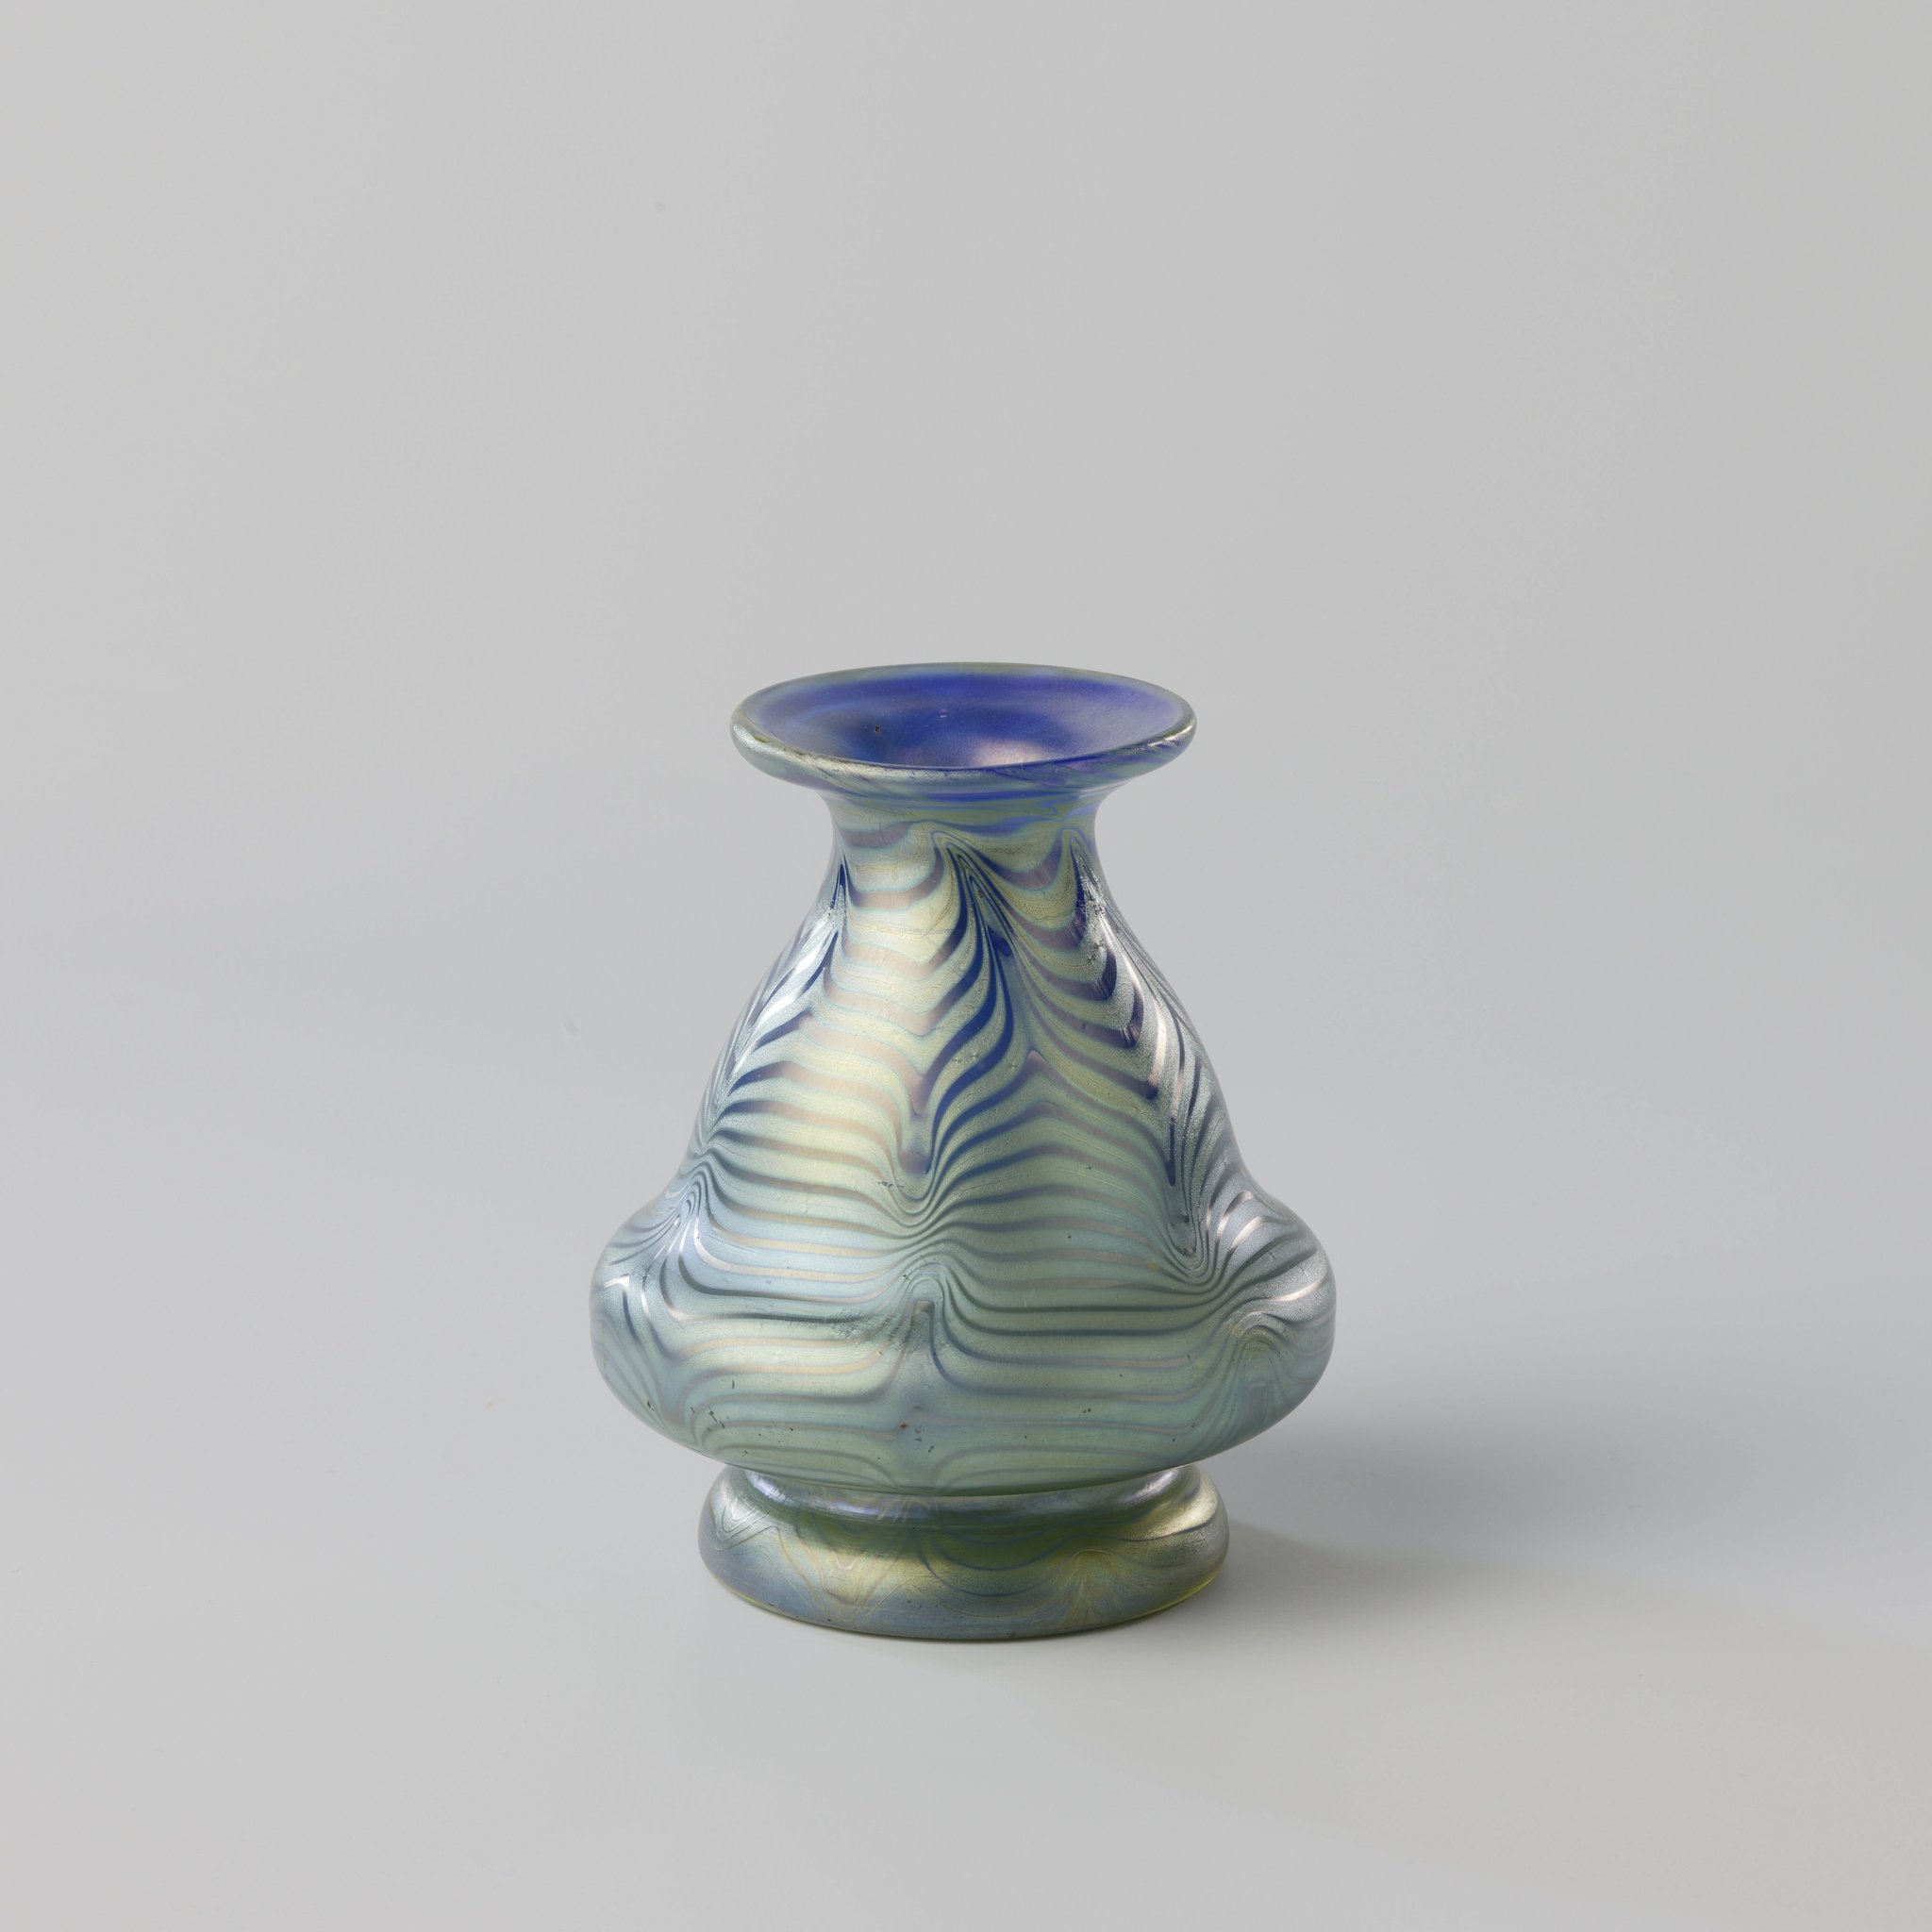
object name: vase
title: Vaas met groene en zilverkleurige draden en een zilverkleurige irisering op een blauw fond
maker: franz hofstötter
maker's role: painter, sculptor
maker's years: 1871-1958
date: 1899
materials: glass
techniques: glassblowing, iridescence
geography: klostermühle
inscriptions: mark: ‘Loetz Austria’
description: Kleine vaas met gewelfde voet, conisch lichaam en uitkragende rand. Op het lichaam gekamde, ingewalste, zachtgroene en zilverkleurige draden, zilverkleurige irisering. Gemerkt op de onderzijde, op de geslepen rand, in radgravure Loetz Austria.